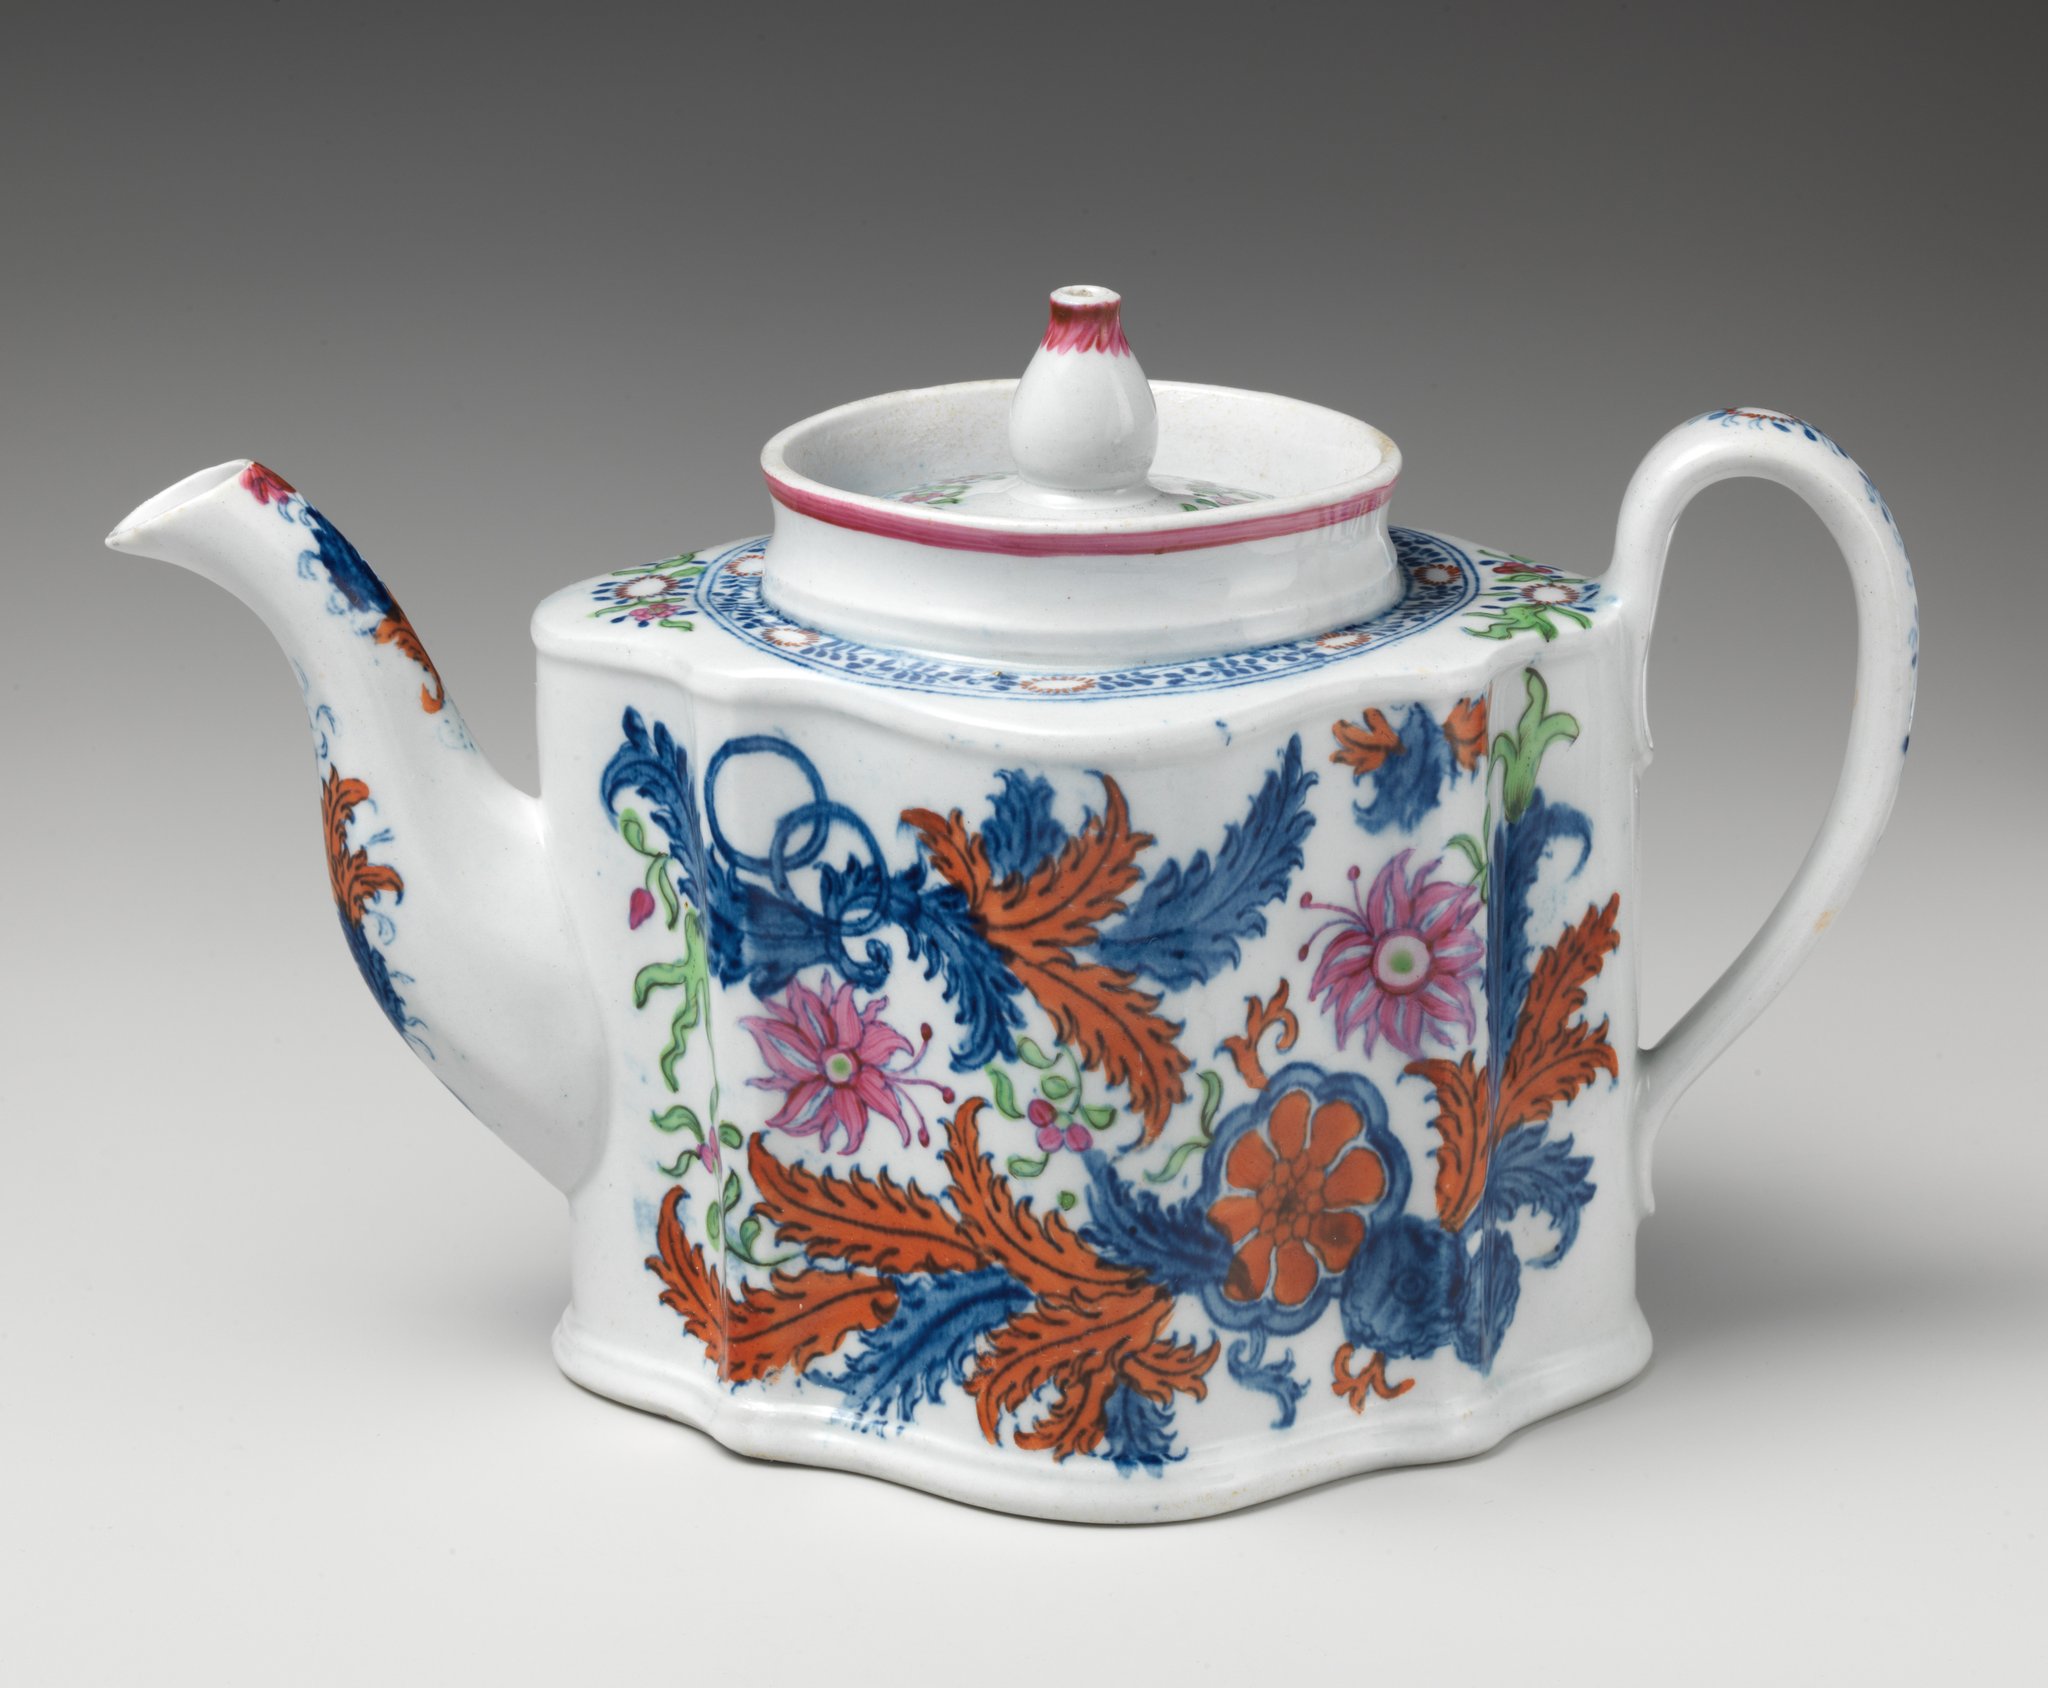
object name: teapot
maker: new hall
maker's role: factory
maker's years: 1781-1835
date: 1790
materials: enamel, hard paste porcelain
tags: flowers,leaves